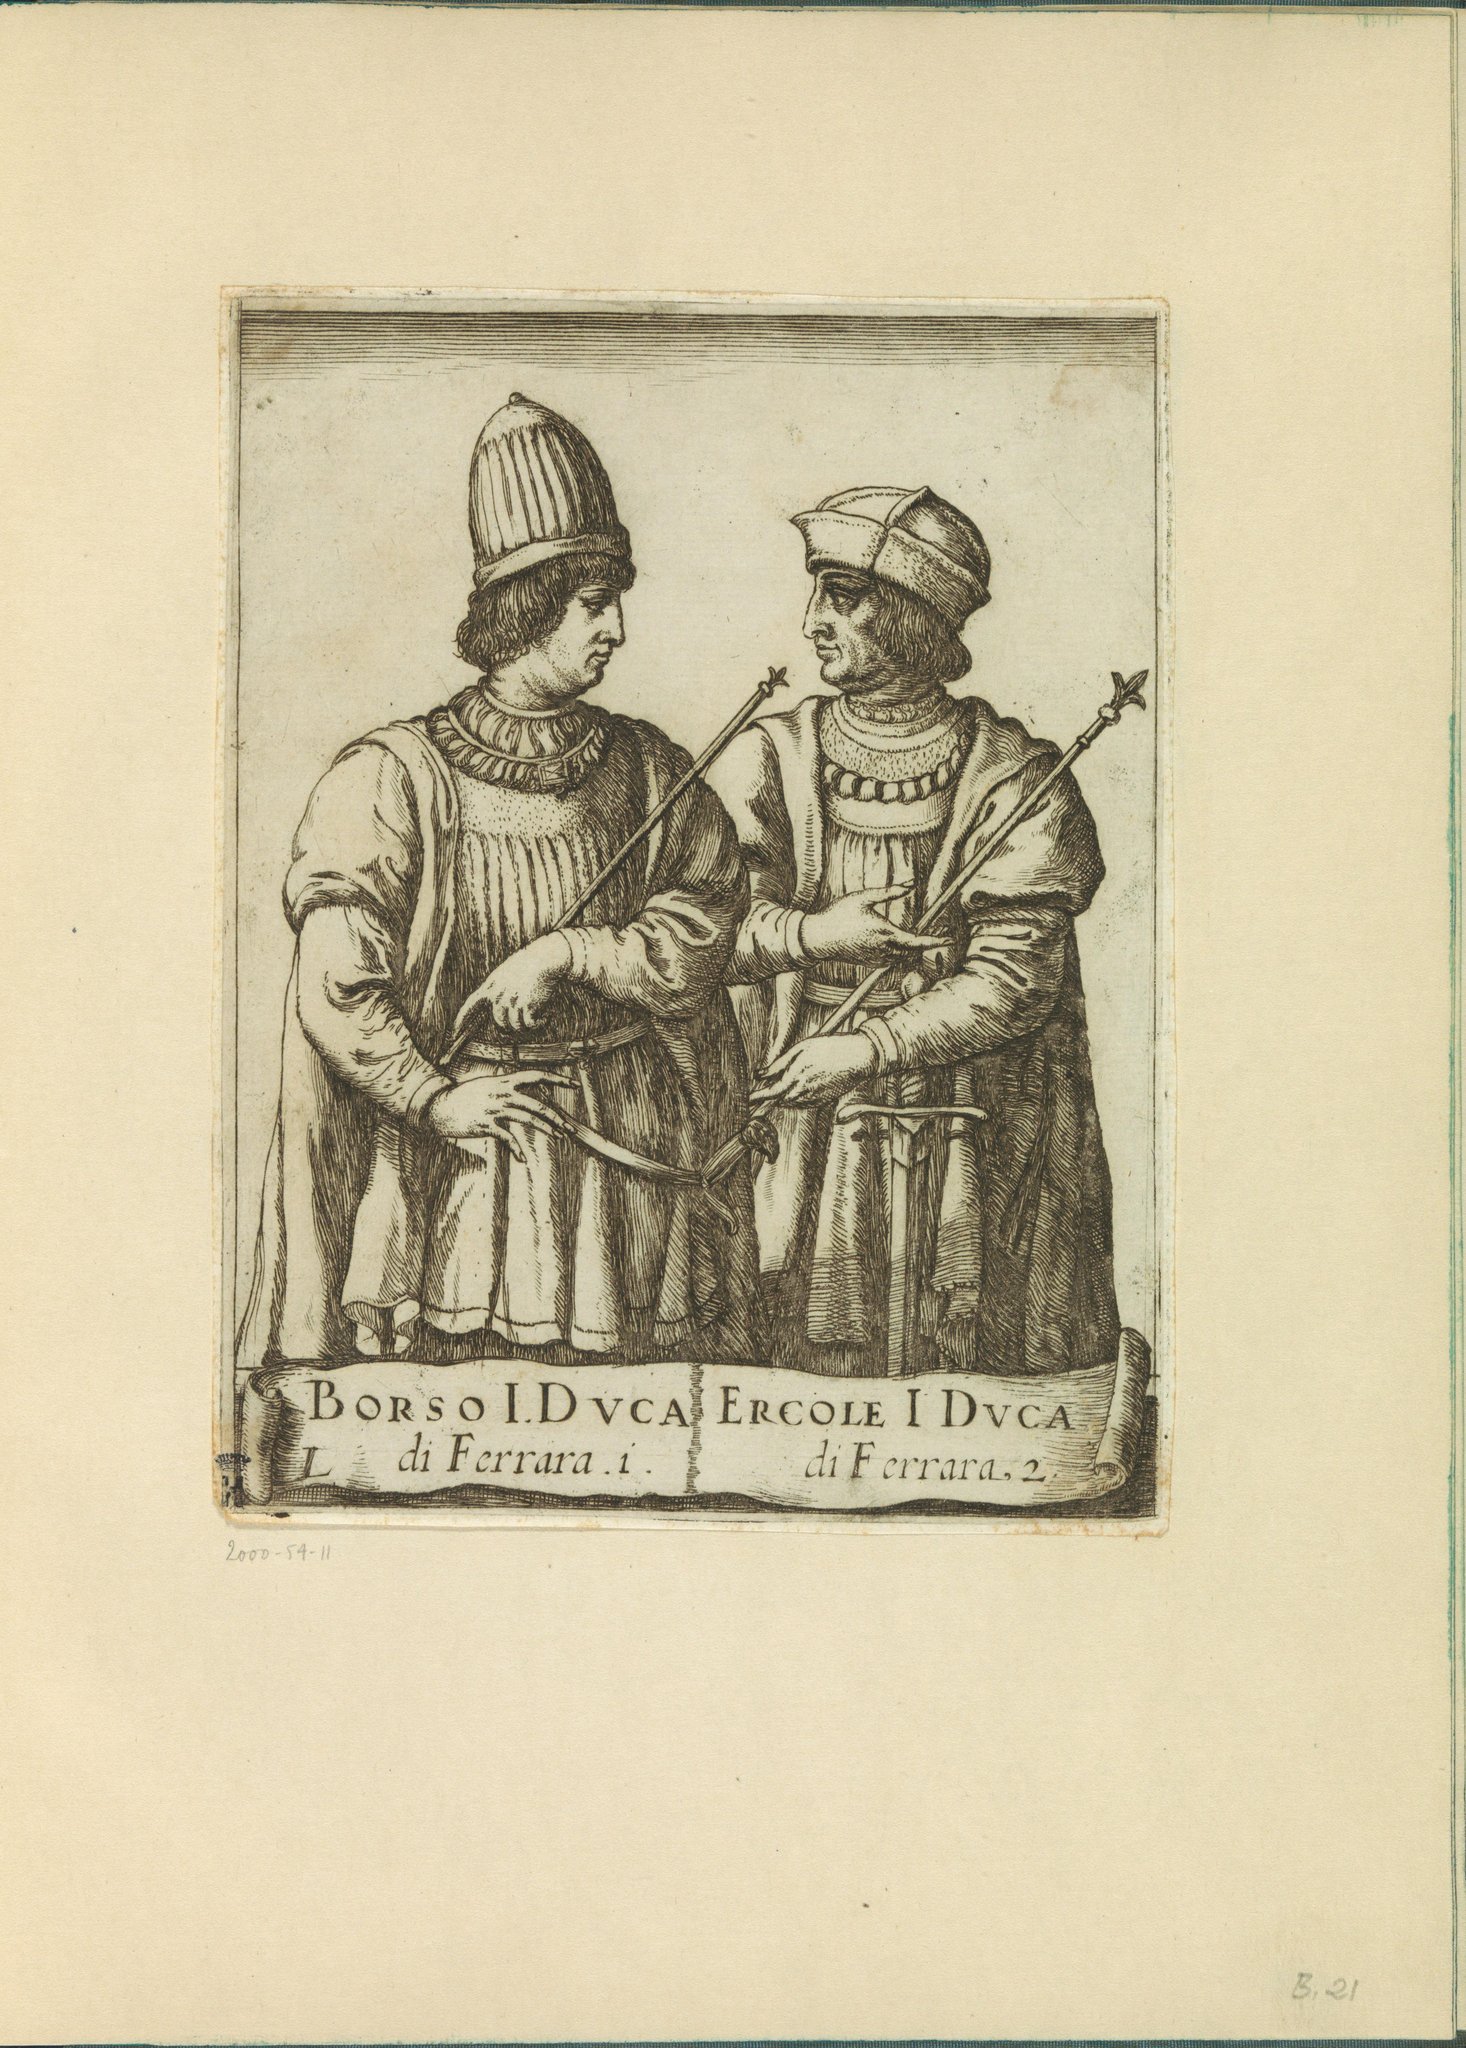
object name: book illustration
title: Heersers van Ferrara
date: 1641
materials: paper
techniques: etching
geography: italy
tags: historical persons, ruler, sovereign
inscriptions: collector's mark: Lugt 1282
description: Prent gebruikt voor Antonio Cariola. Ritratti De' Ser.mi Principi d'Este Sig.ri di Ferrara, Ferrara: Francesco Suzzi, 1641.